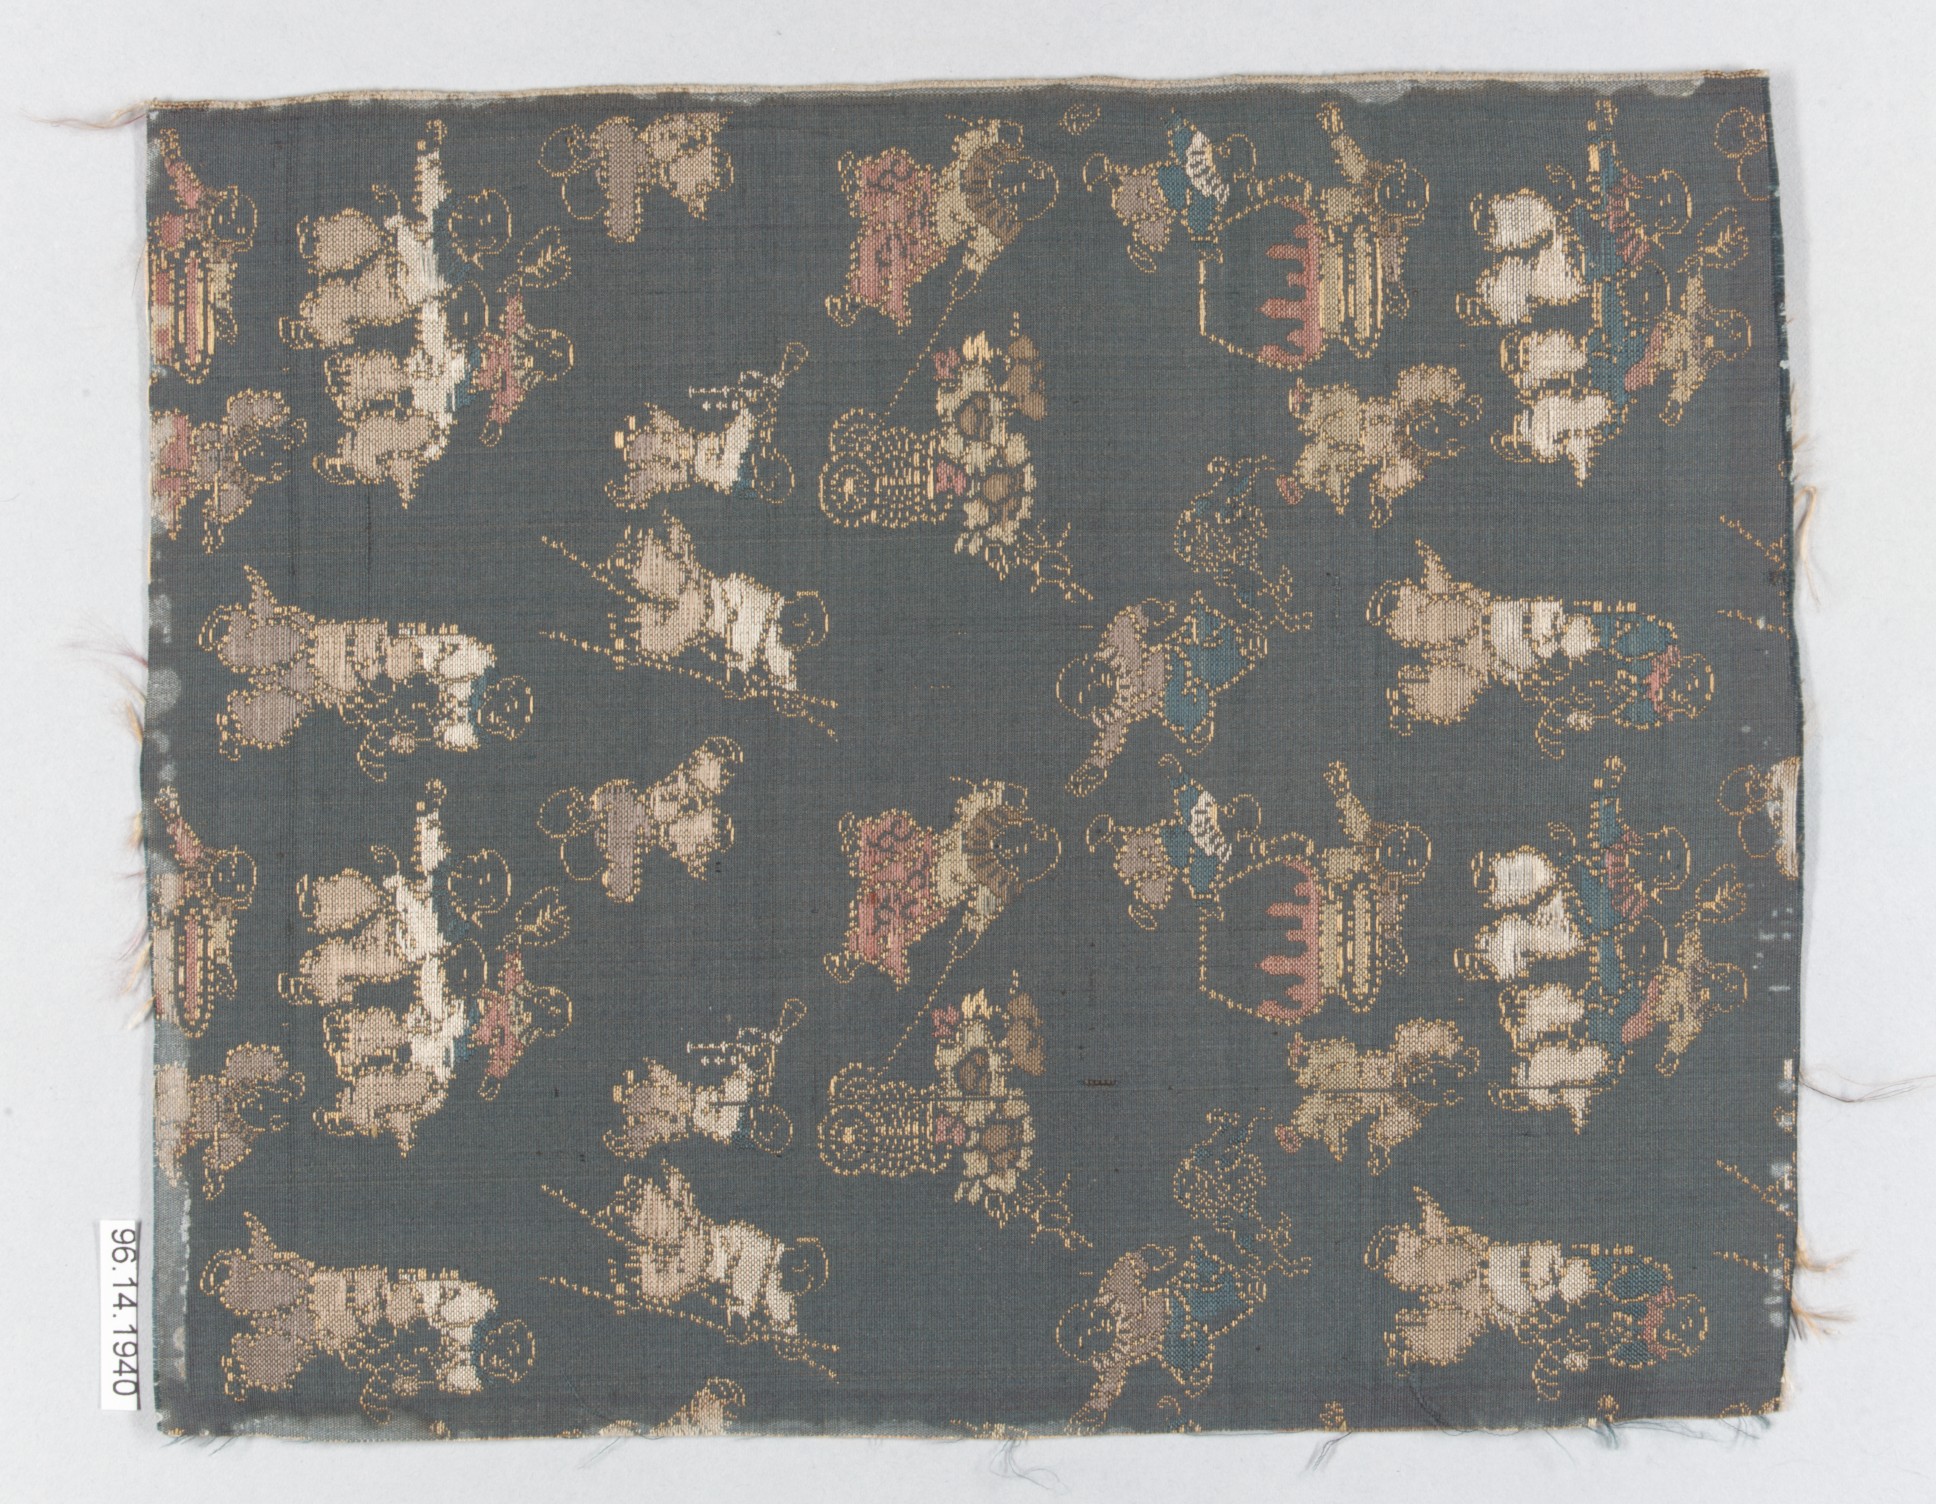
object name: piece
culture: japanese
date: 1801-1900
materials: silk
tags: children,playing